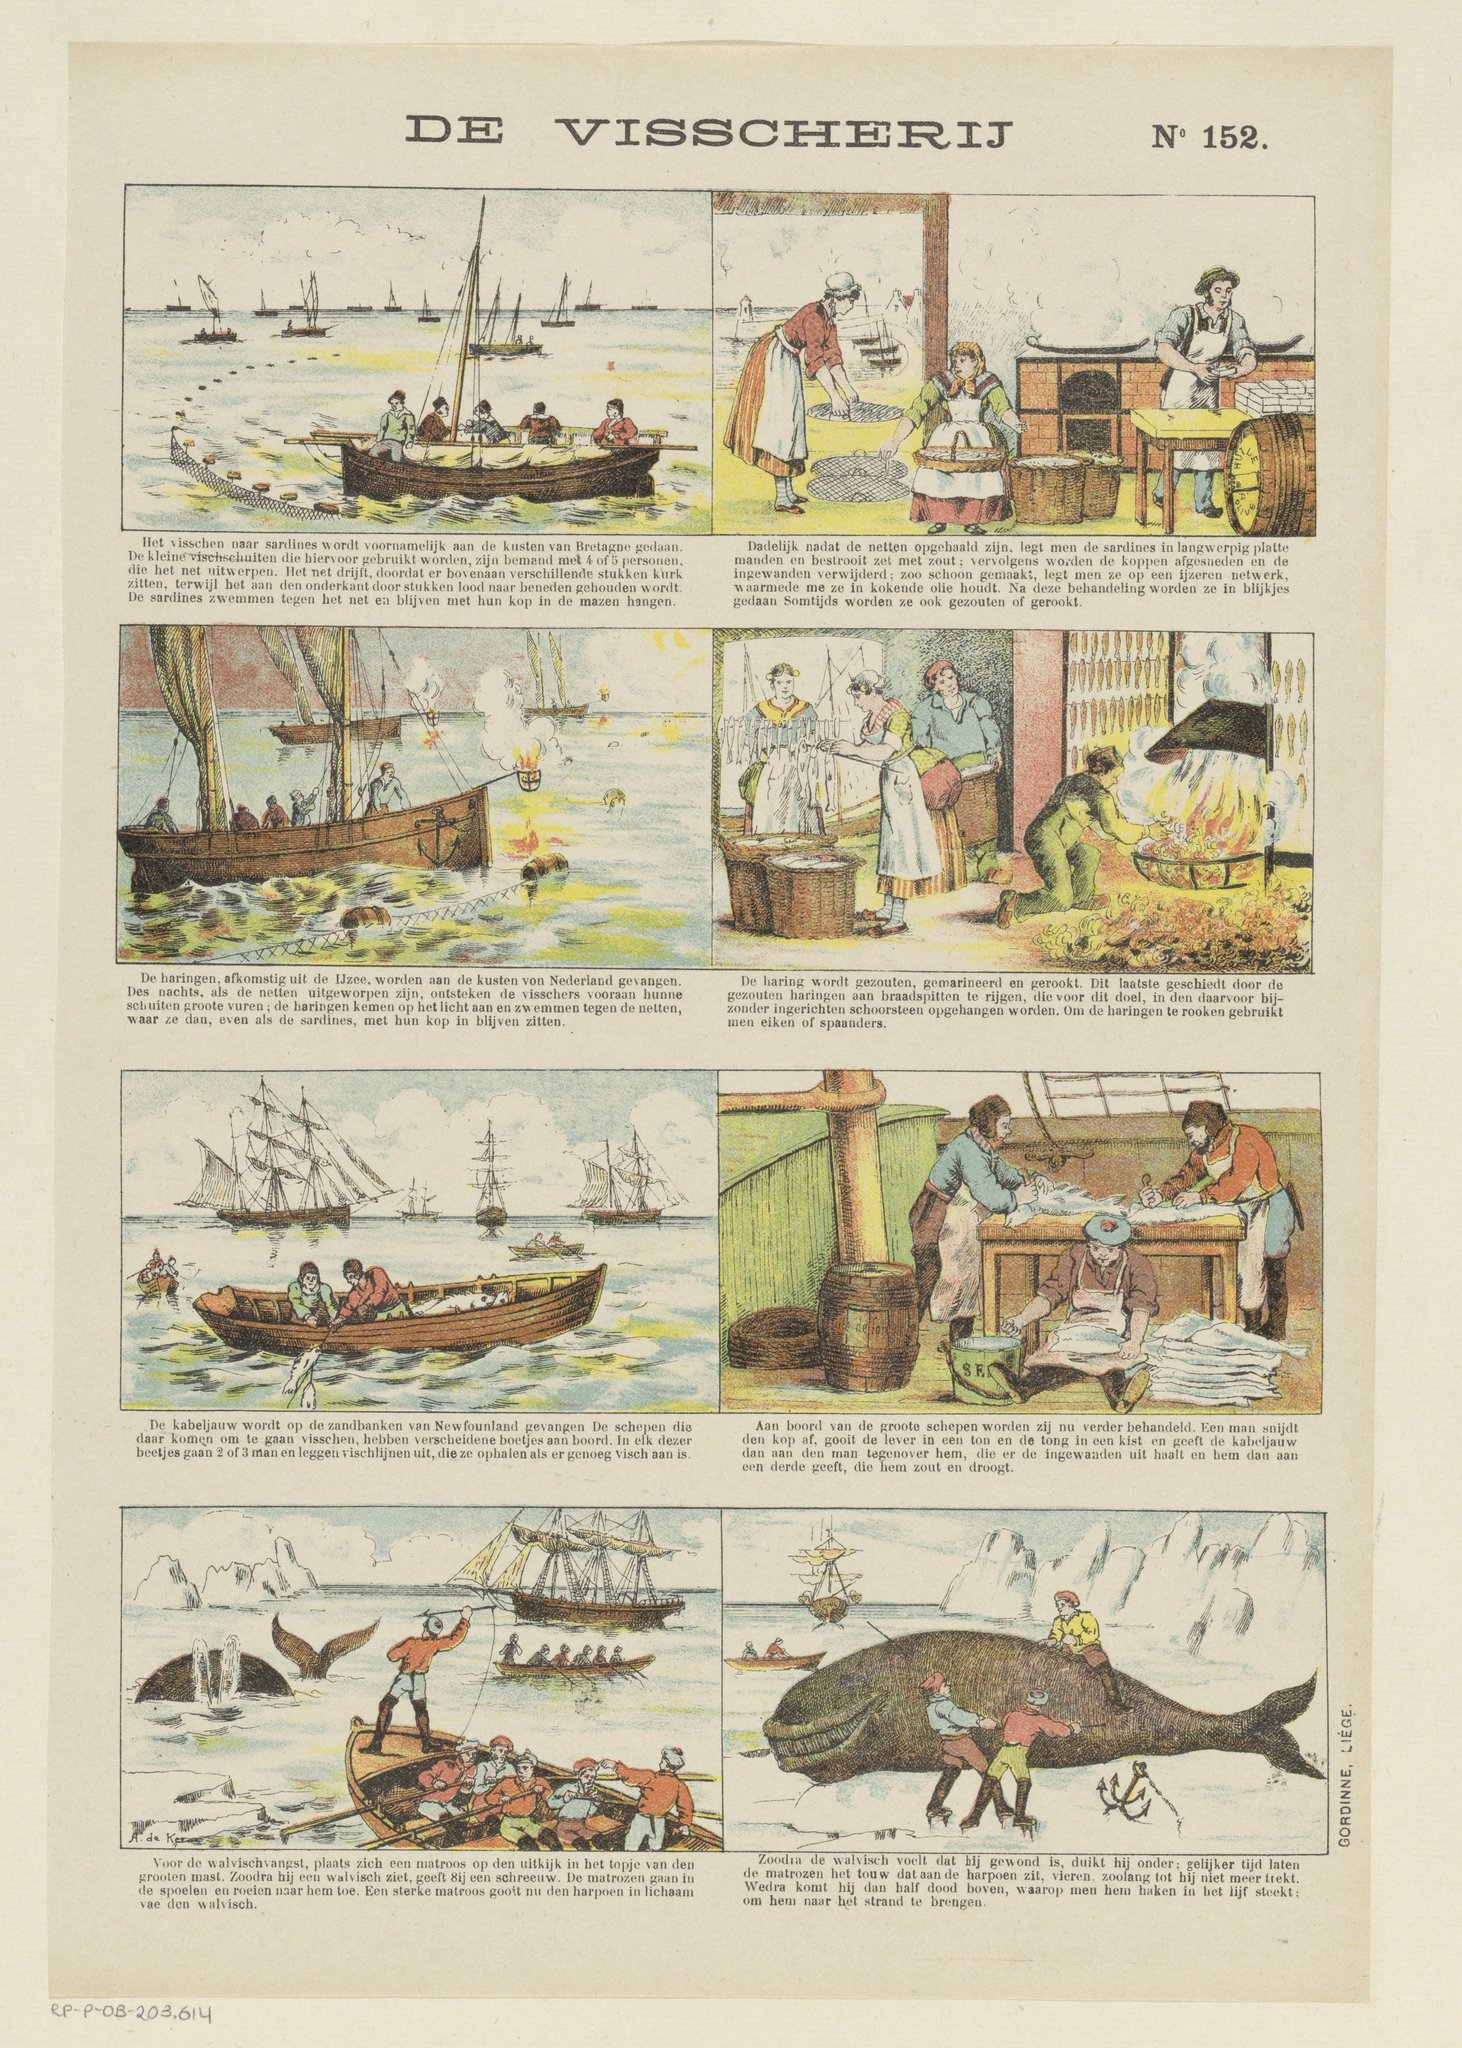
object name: print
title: De visscherij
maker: a. de ker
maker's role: print maker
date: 1894-1959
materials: paper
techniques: lithograph, letterpress printing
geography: liège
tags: commercial fishery, herring fishery, whale fishery, whaling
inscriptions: collector's mark: Lugt 2760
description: Blad met 8 voorstellingen over het vissen naar sardines, haring, kabeljauw en walvissen. Onder elke afbeelding een onderschrift. Genummerd rechtsboven: No 152.